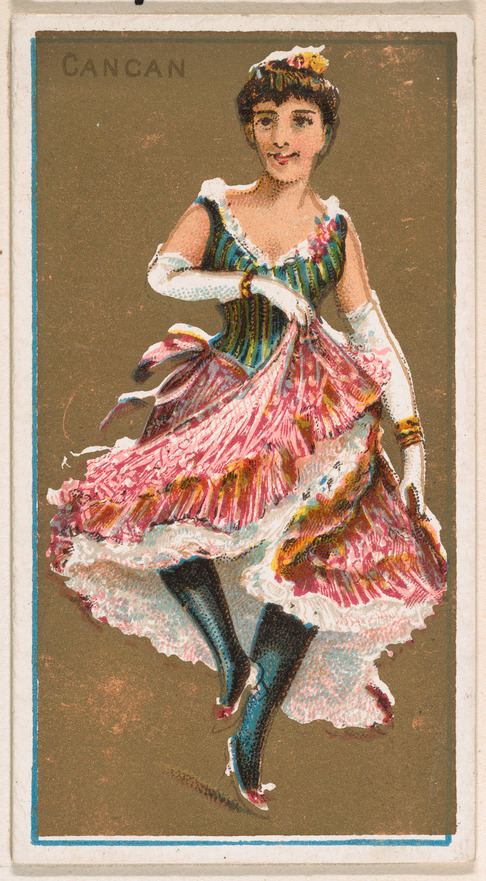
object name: print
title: Cancan, from National Dances (N225, Type 1) issued by Kinney Bros.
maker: kinney brothers tobacco company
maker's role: publisher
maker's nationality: american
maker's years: 1869-2011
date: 1889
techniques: color lithograph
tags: dance,women,dancing